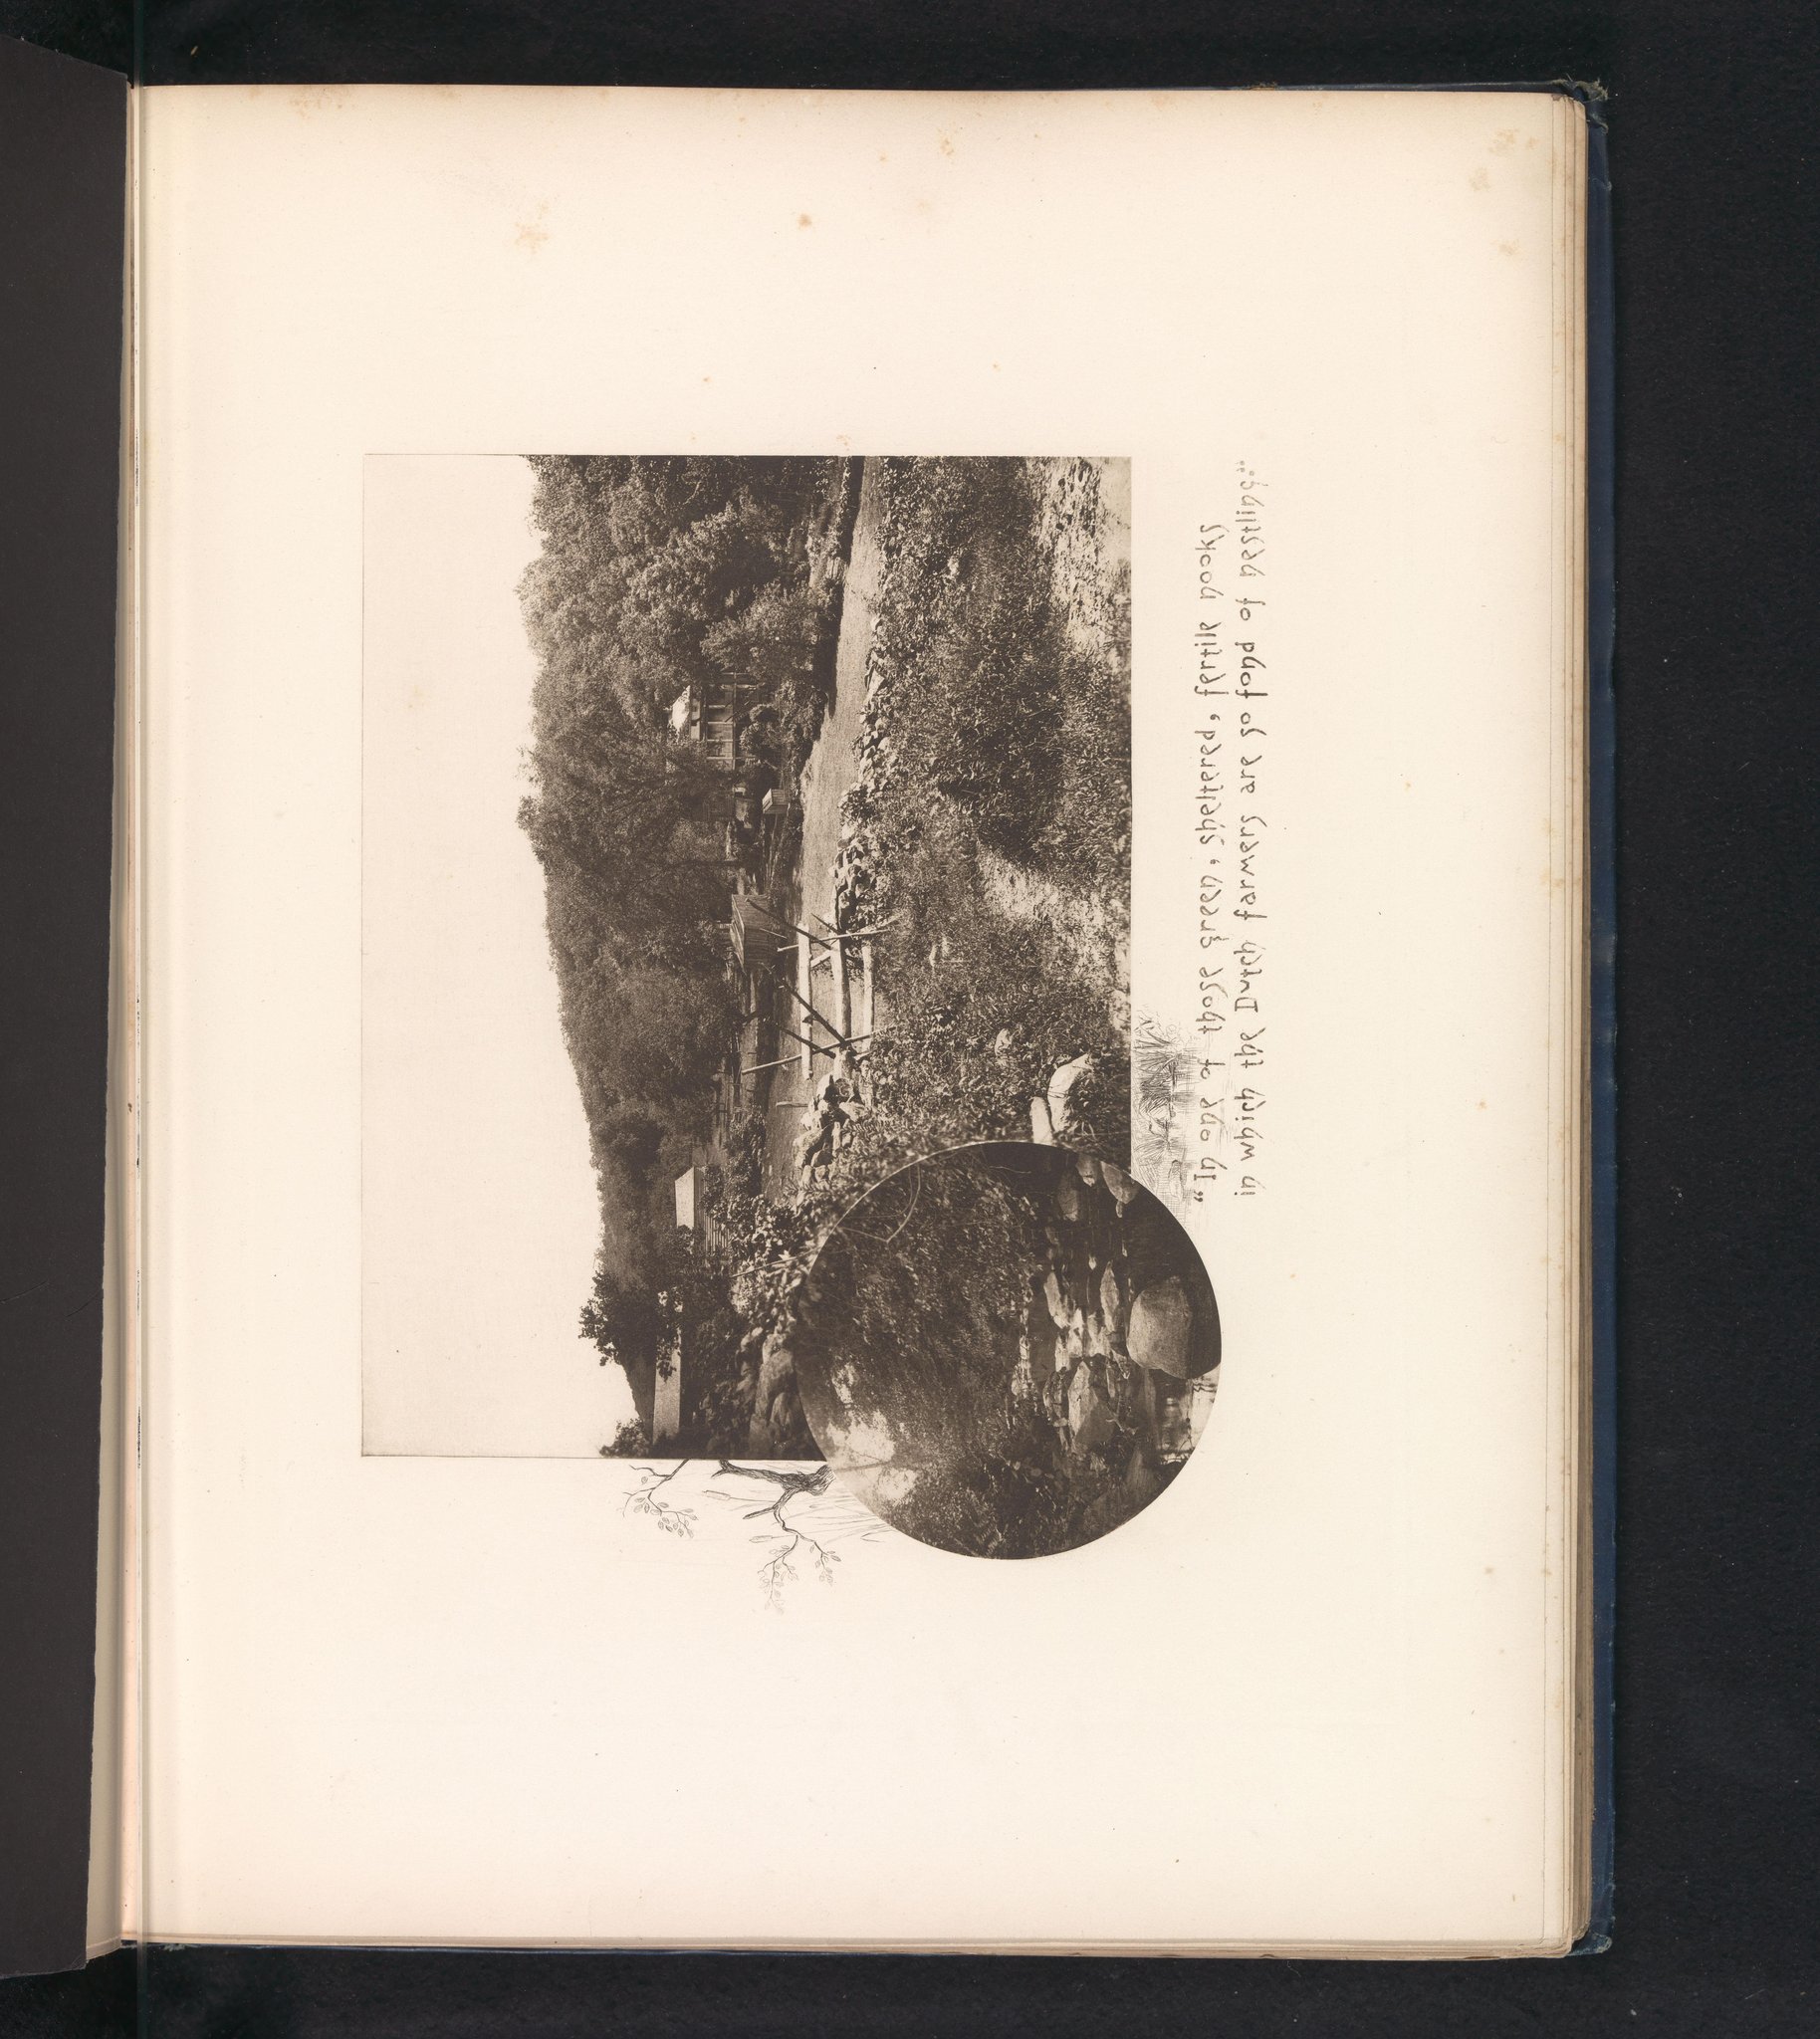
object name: photomechanical print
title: Beek te Sleepy Hollow en een gezicht op een erf te Sleepy Hollow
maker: james leon williams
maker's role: fotograaf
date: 1882-1887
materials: paper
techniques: photoaquatint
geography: sleepy hollow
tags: brook, farm or solitary house in landscape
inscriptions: inscription: ‘"In one of those (...) of nestling"’